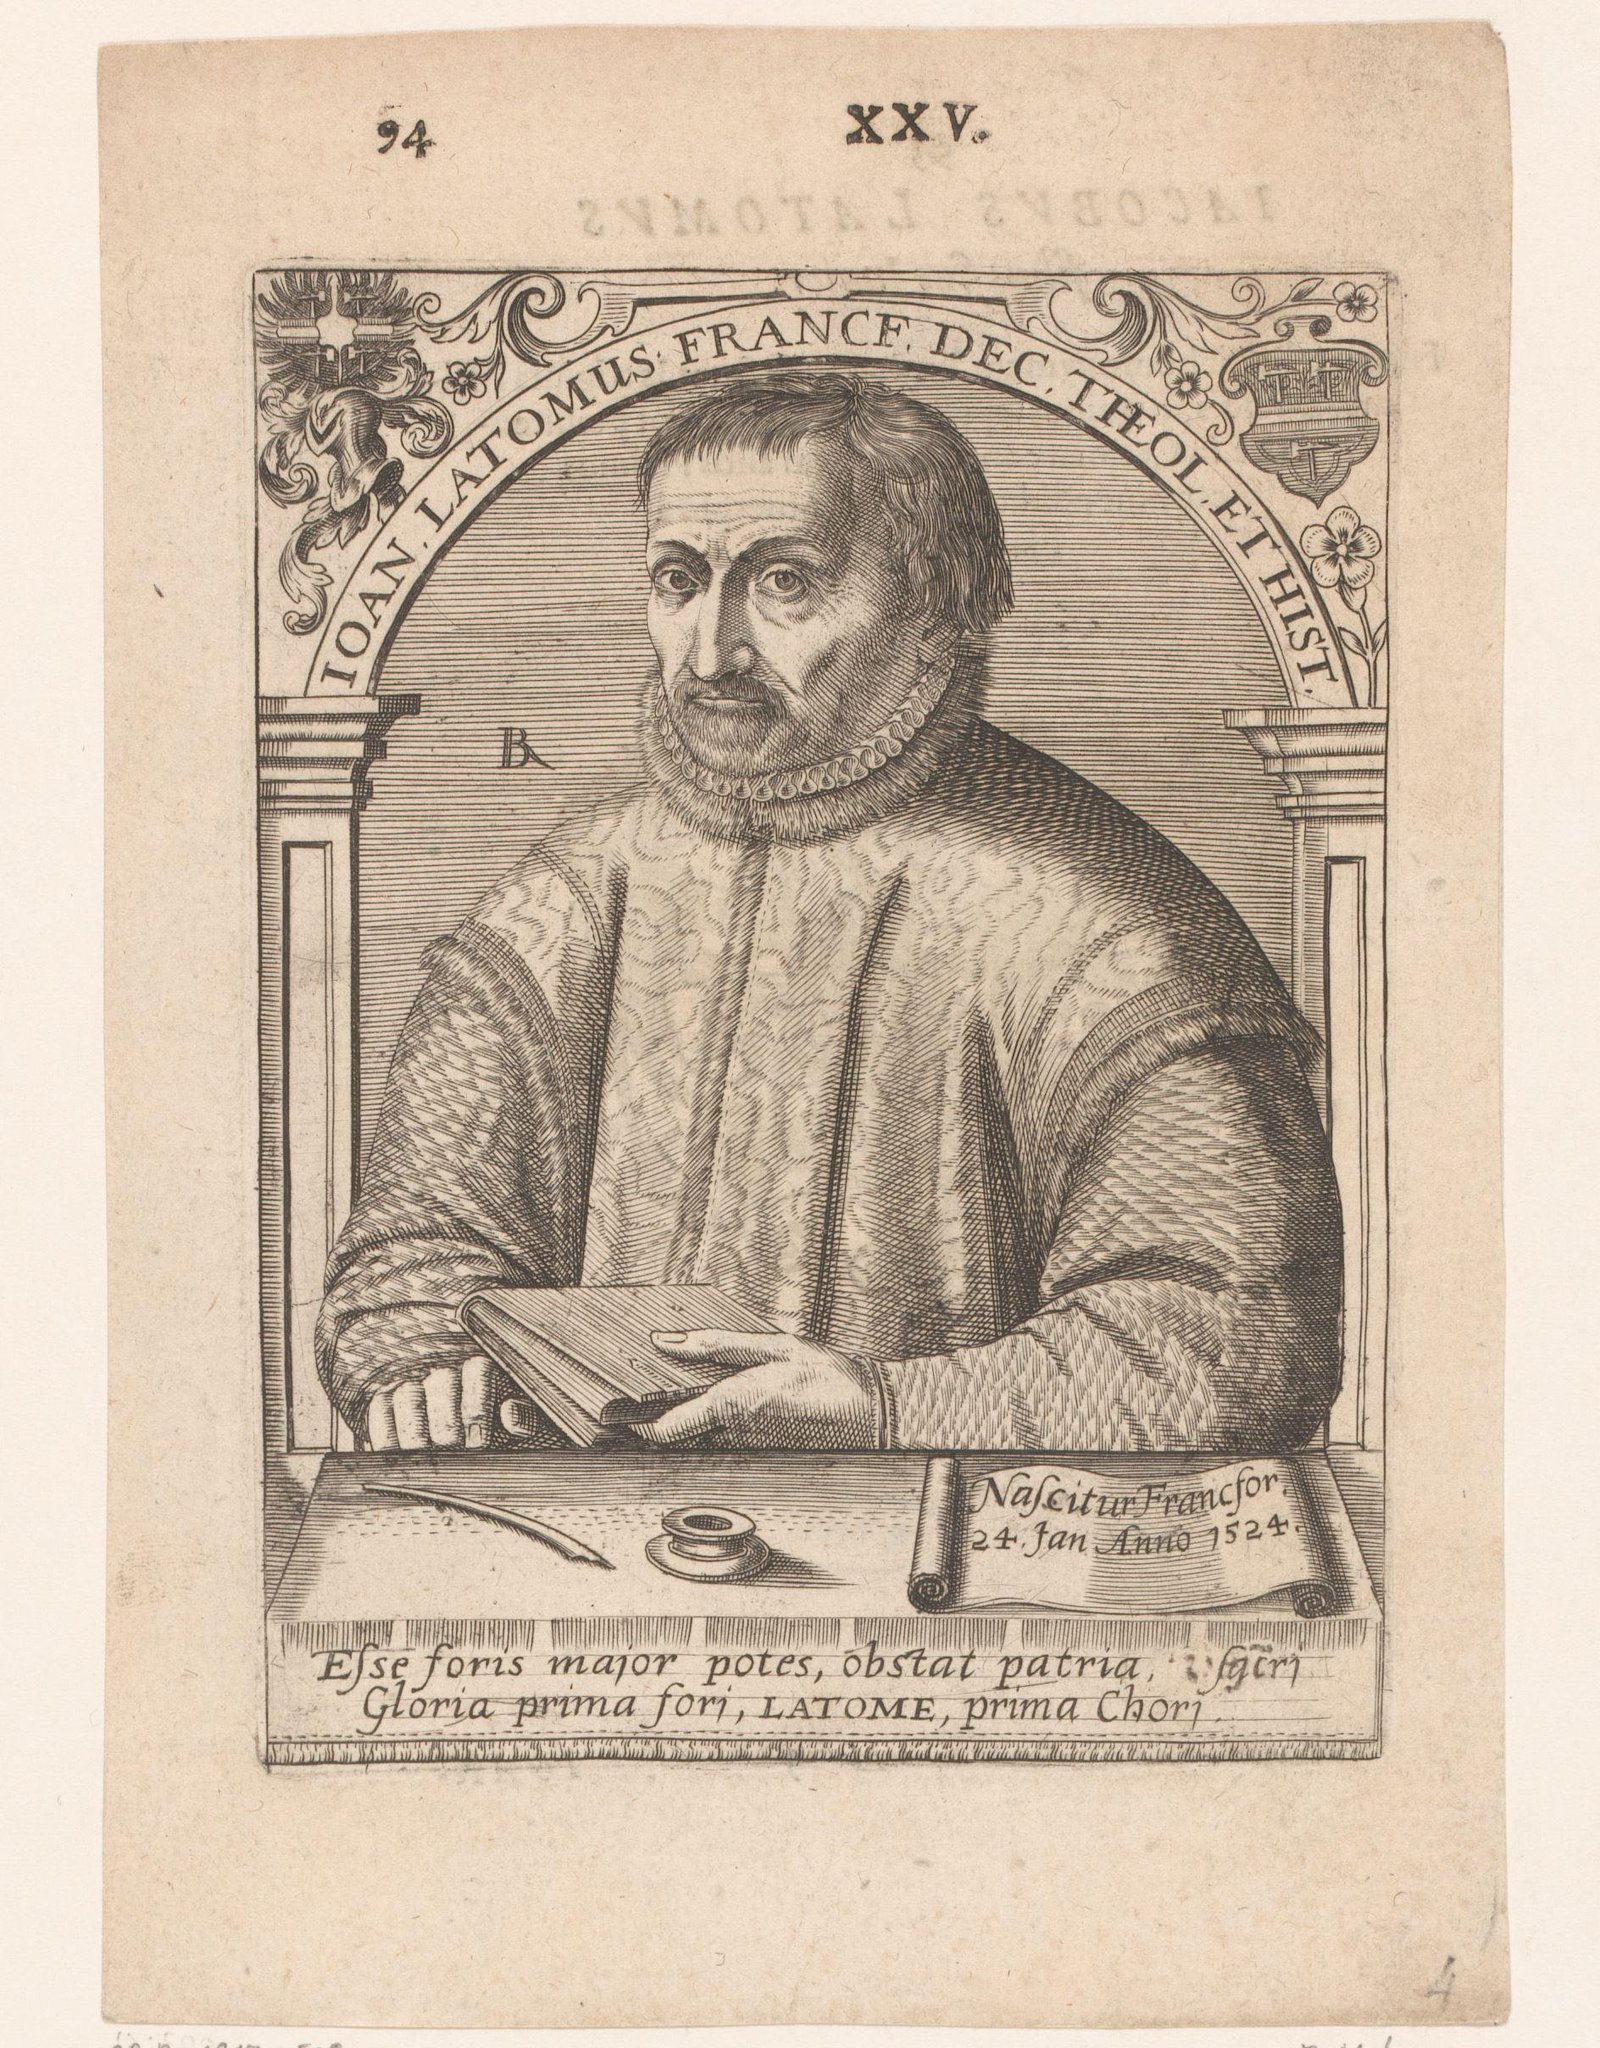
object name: print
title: Serie portretten van vijftiende- en zestiende-eeuwse geleerden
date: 1597-1599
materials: paper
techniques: engraving, letterpress printing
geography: france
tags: helmet, flowers, historical persons, armorial bearing, heraldry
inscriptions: collector's mark: Lugt 2228